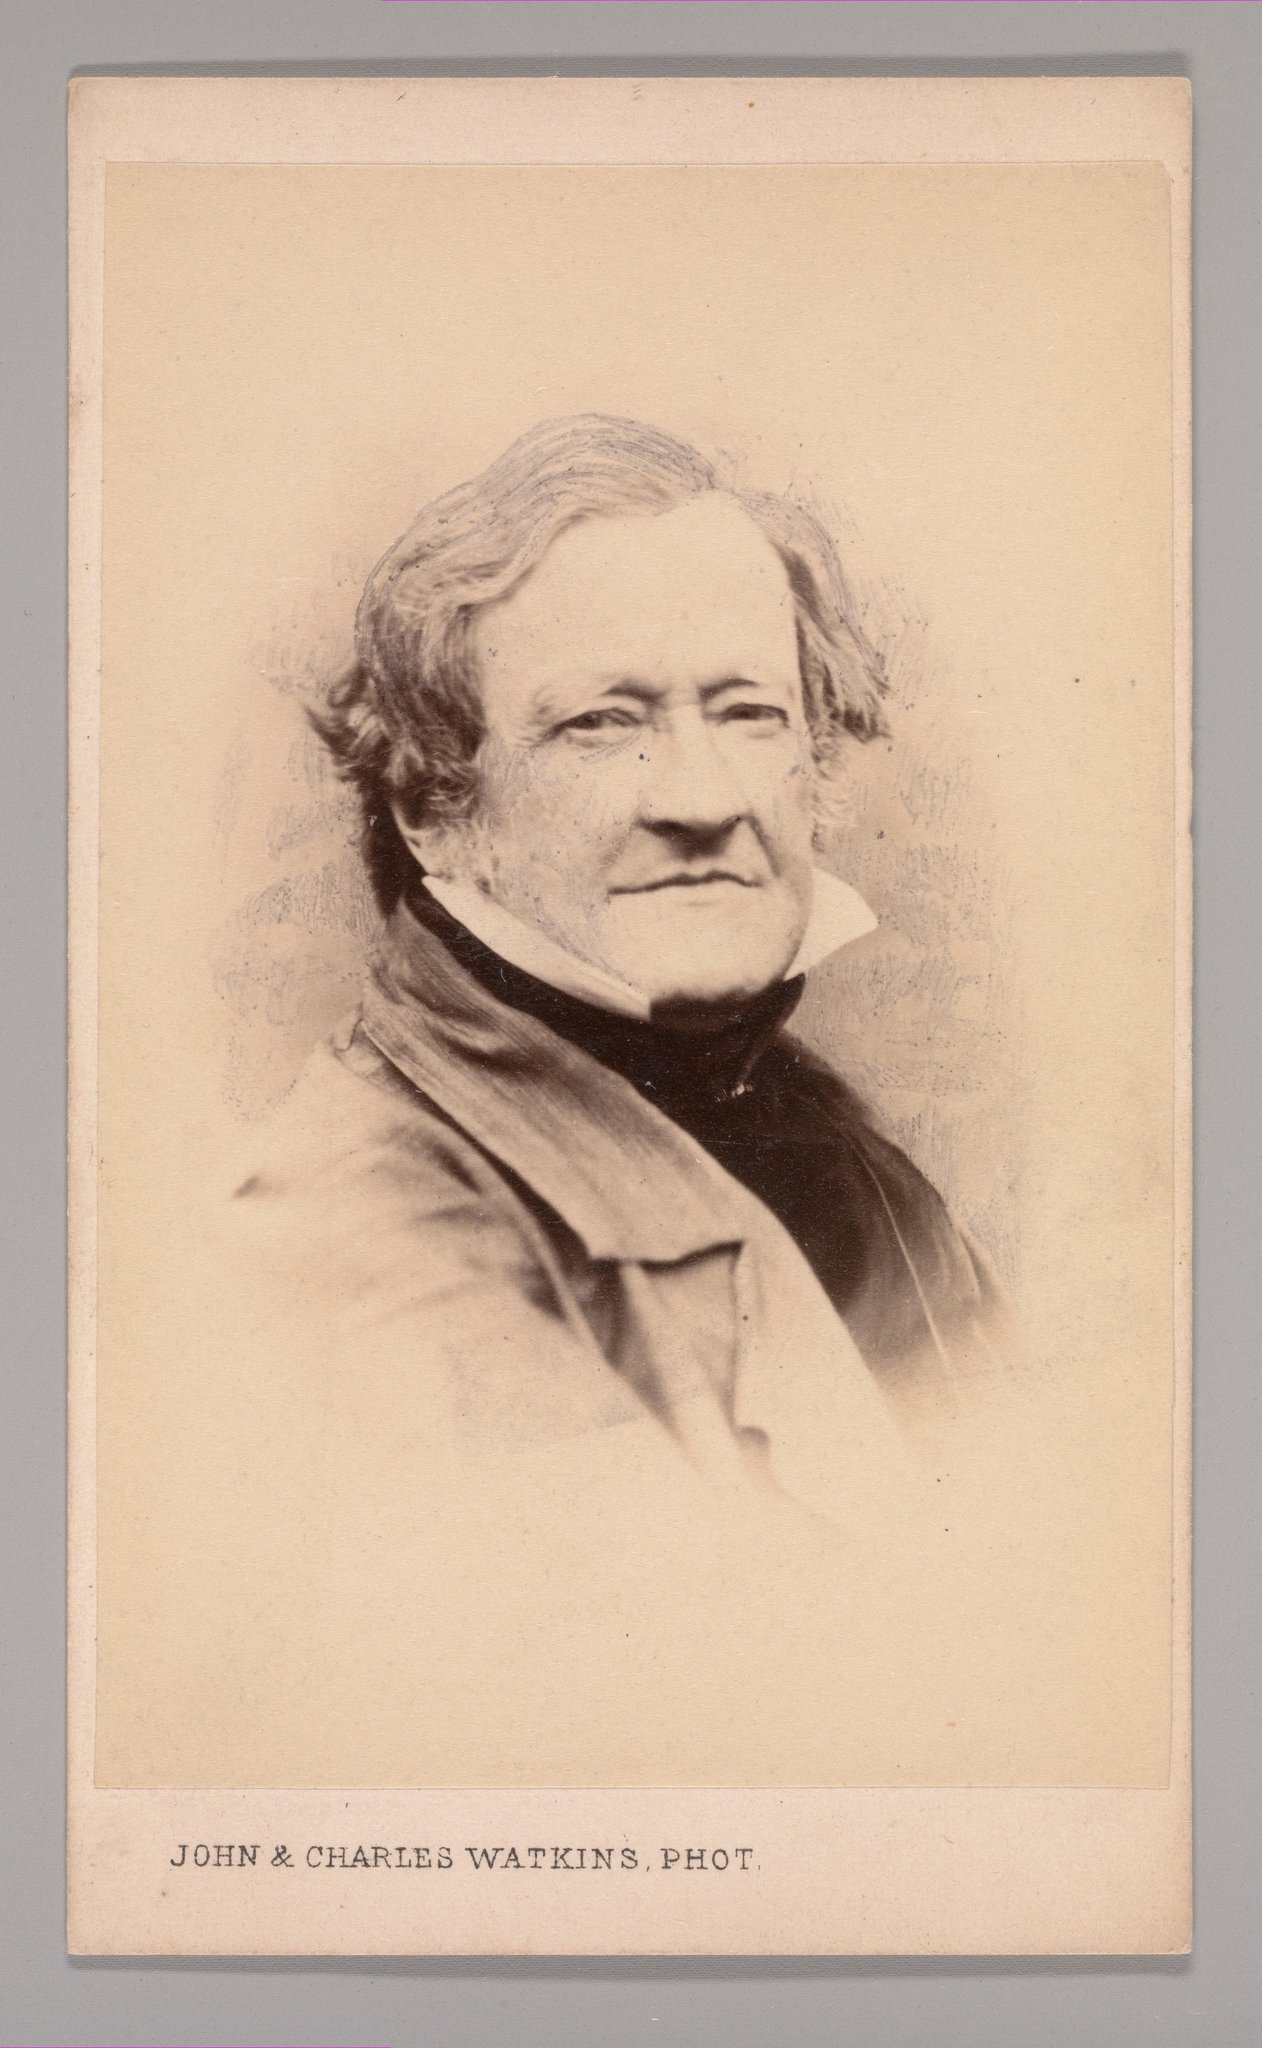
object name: carte de visite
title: [Unknown Subject]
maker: john and charles watkins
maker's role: photography studio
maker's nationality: british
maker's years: 1840-1875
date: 1860-1869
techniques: albumen silver print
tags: men,portraits